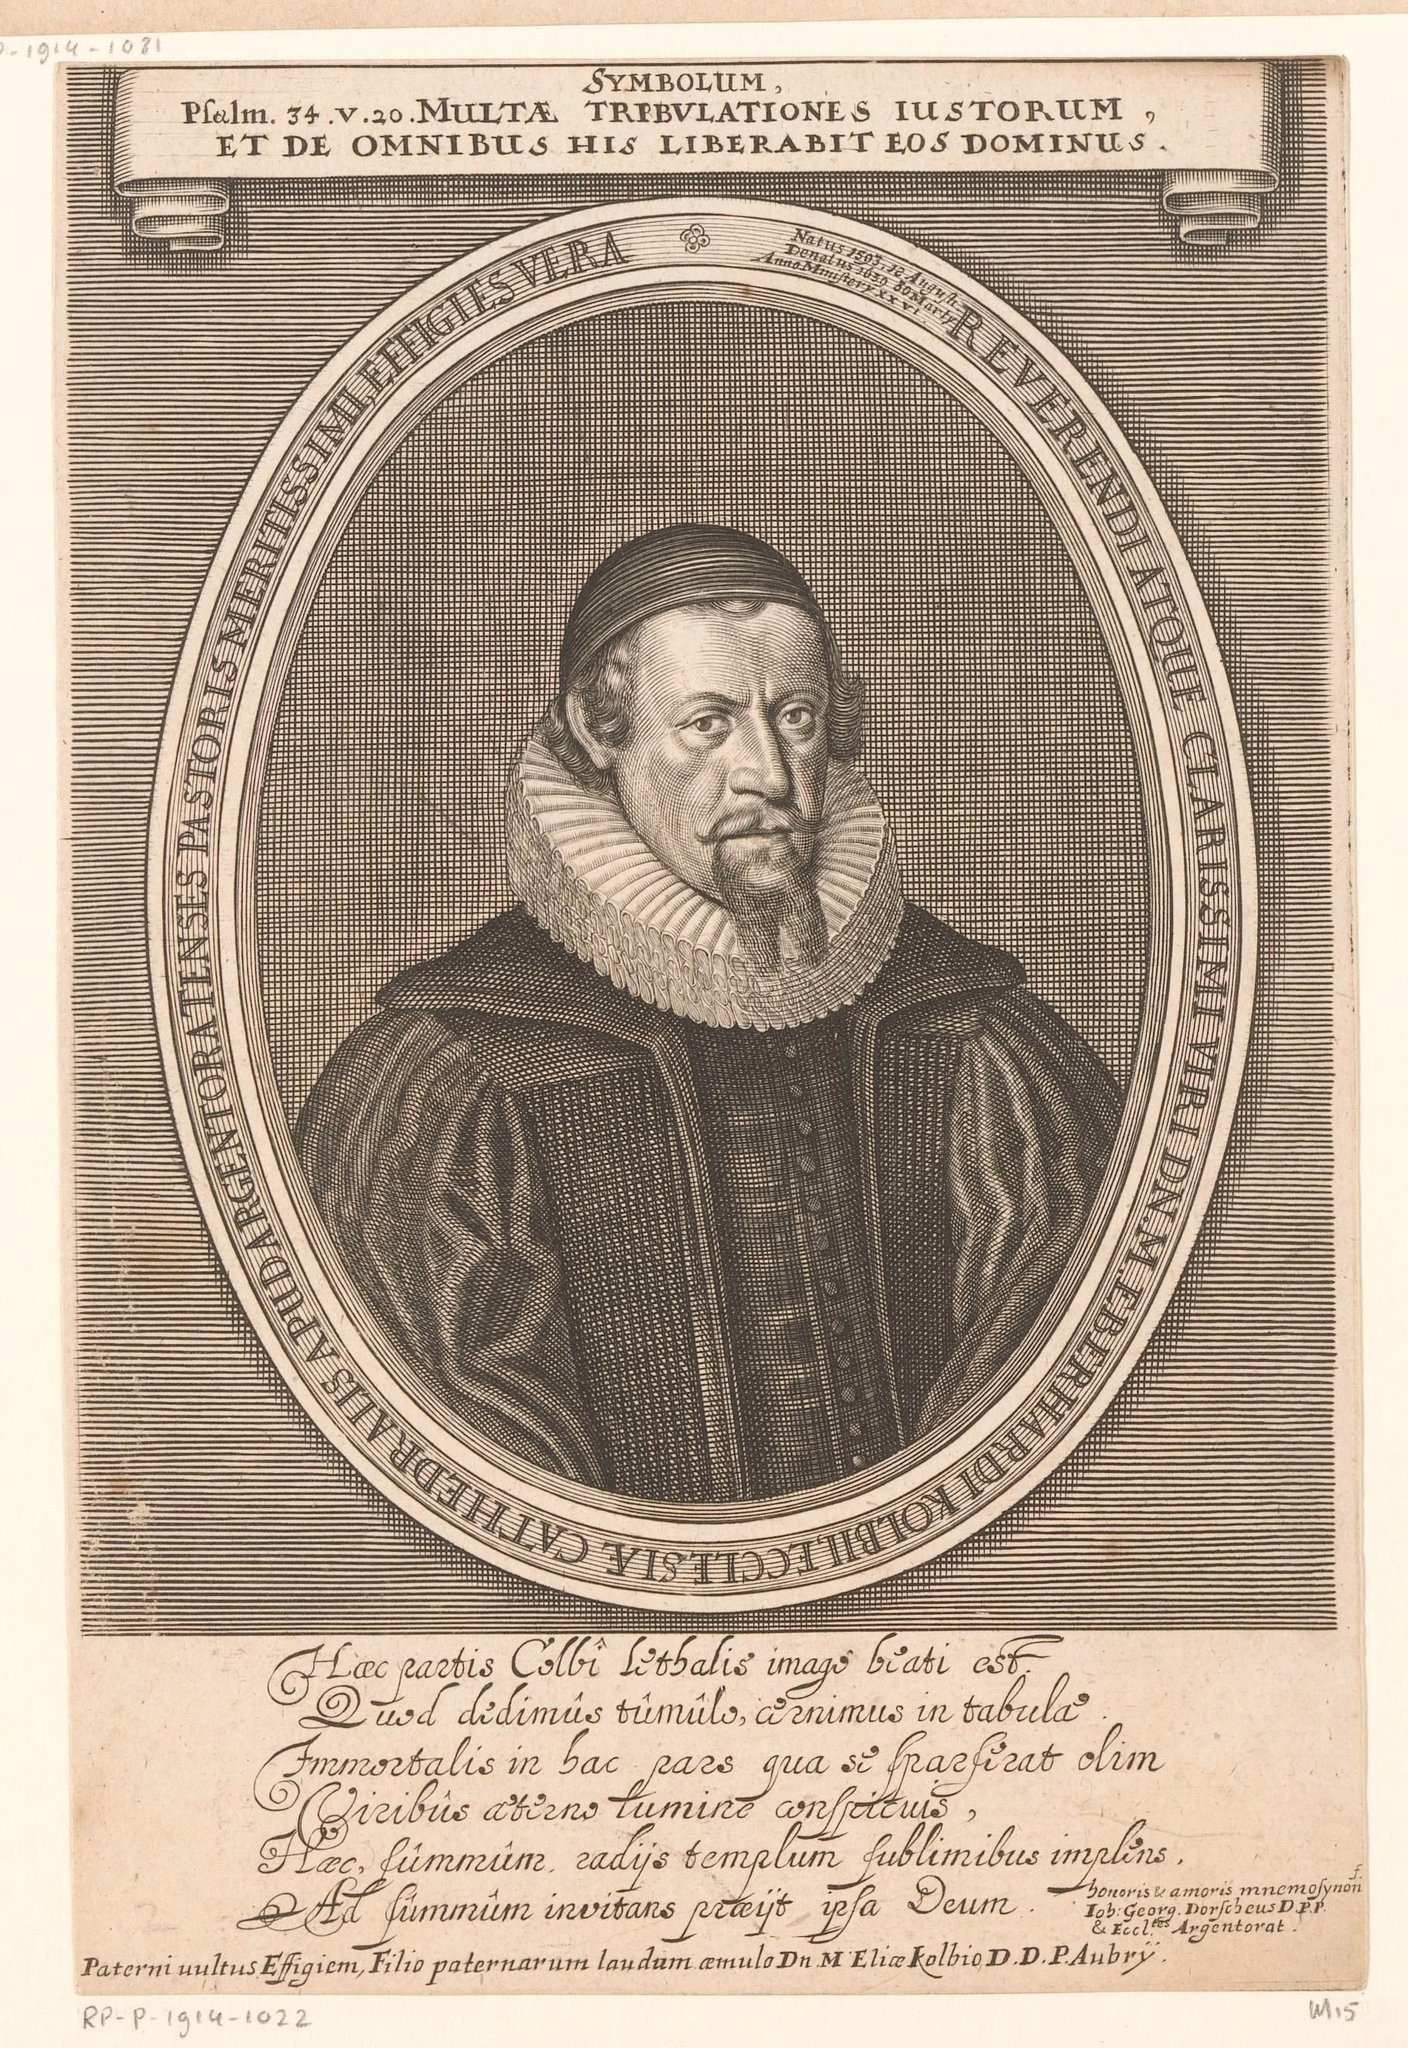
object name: print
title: Portret van Eberhard Kolb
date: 1639-1659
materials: paper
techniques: engraving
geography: straatsburg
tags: historical persons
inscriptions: collector's mark: Lugt 2228